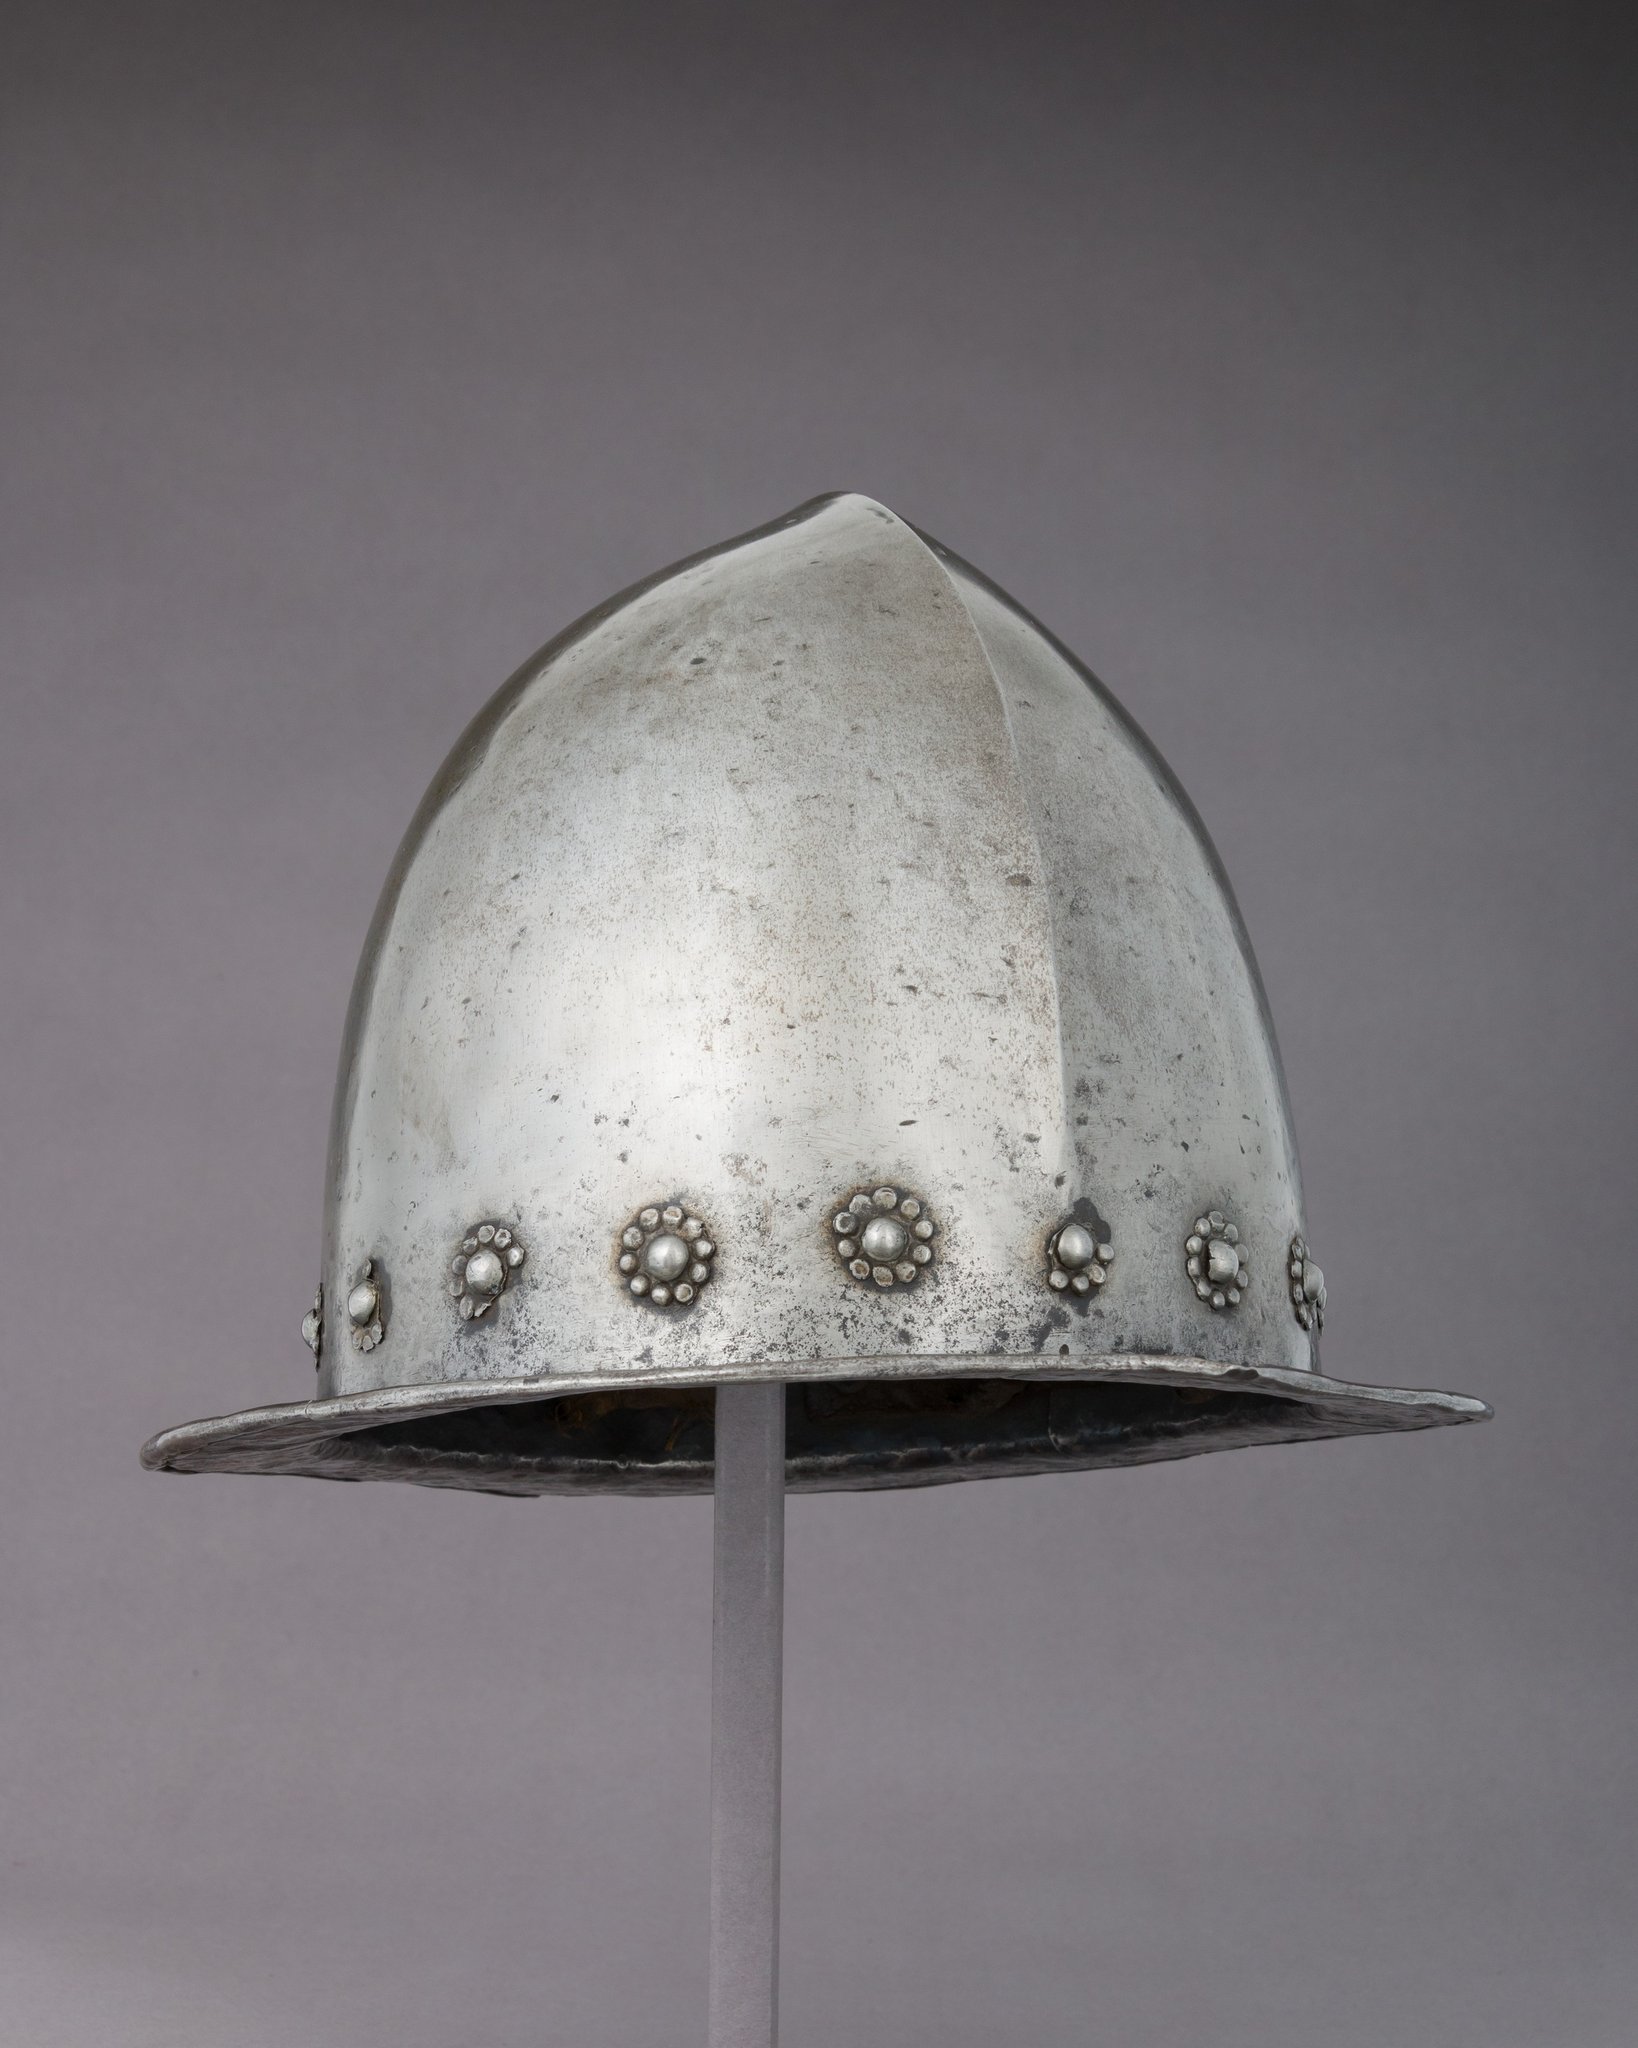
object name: cabasset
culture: italian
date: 1601-1700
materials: leather, steel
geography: italy